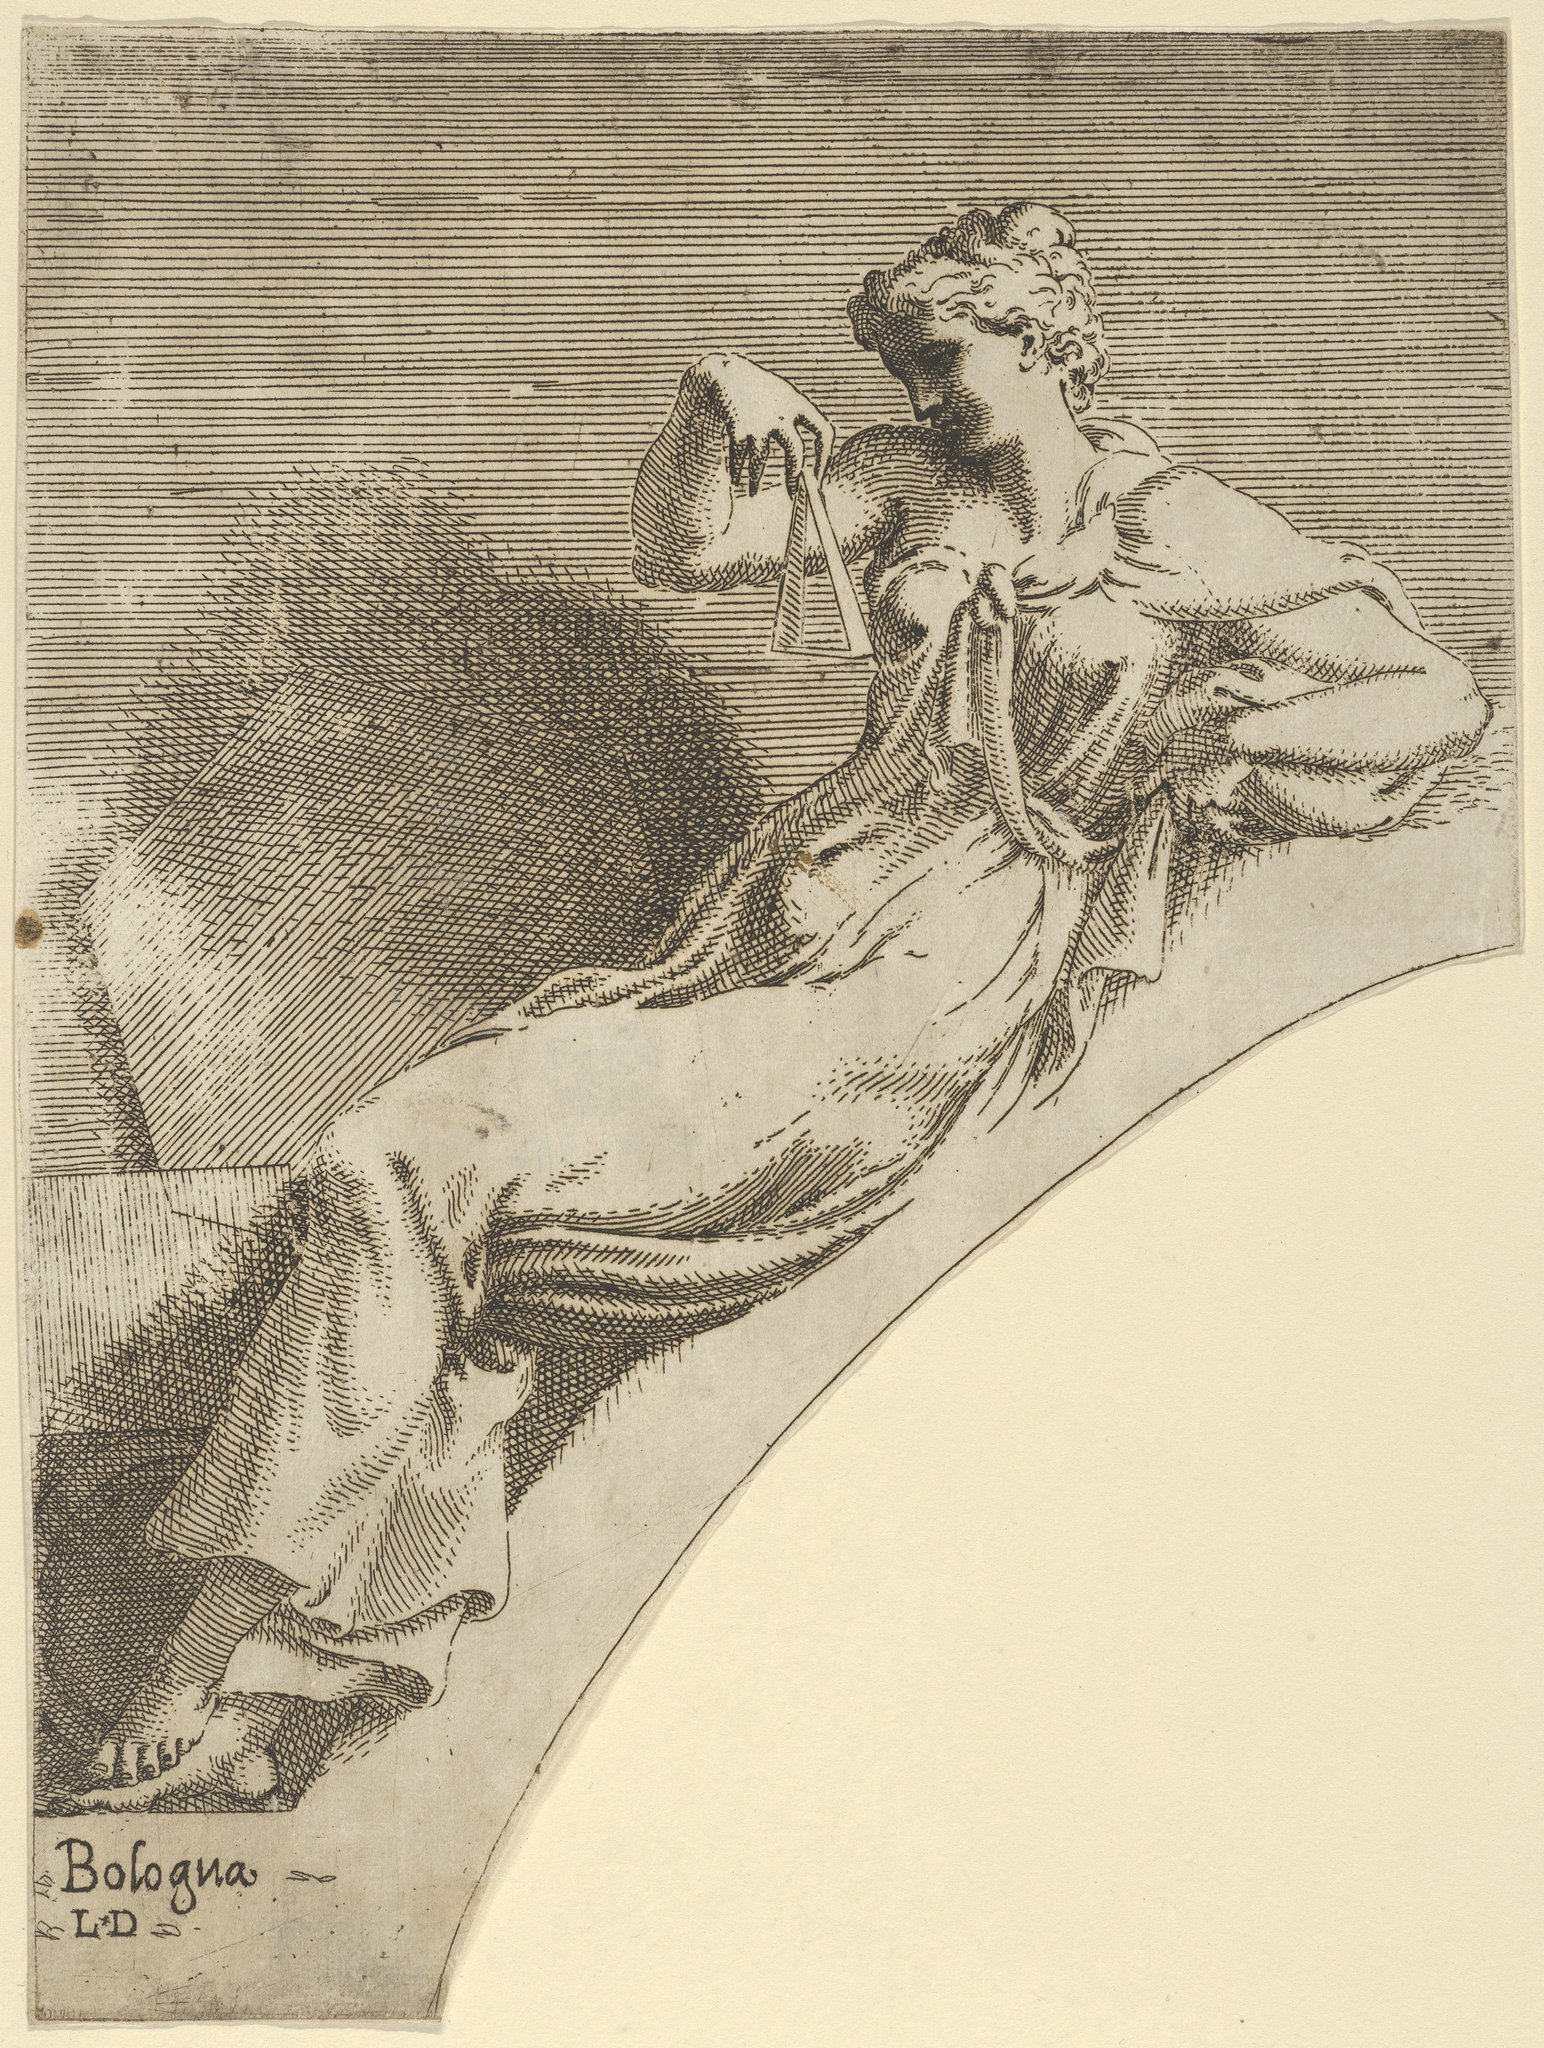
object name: print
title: Erato, from "Twelve Muses and Goddesses"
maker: léon davent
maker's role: artist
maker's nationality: french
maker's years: 1540-1556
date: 1540-1545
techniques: etching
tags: muses